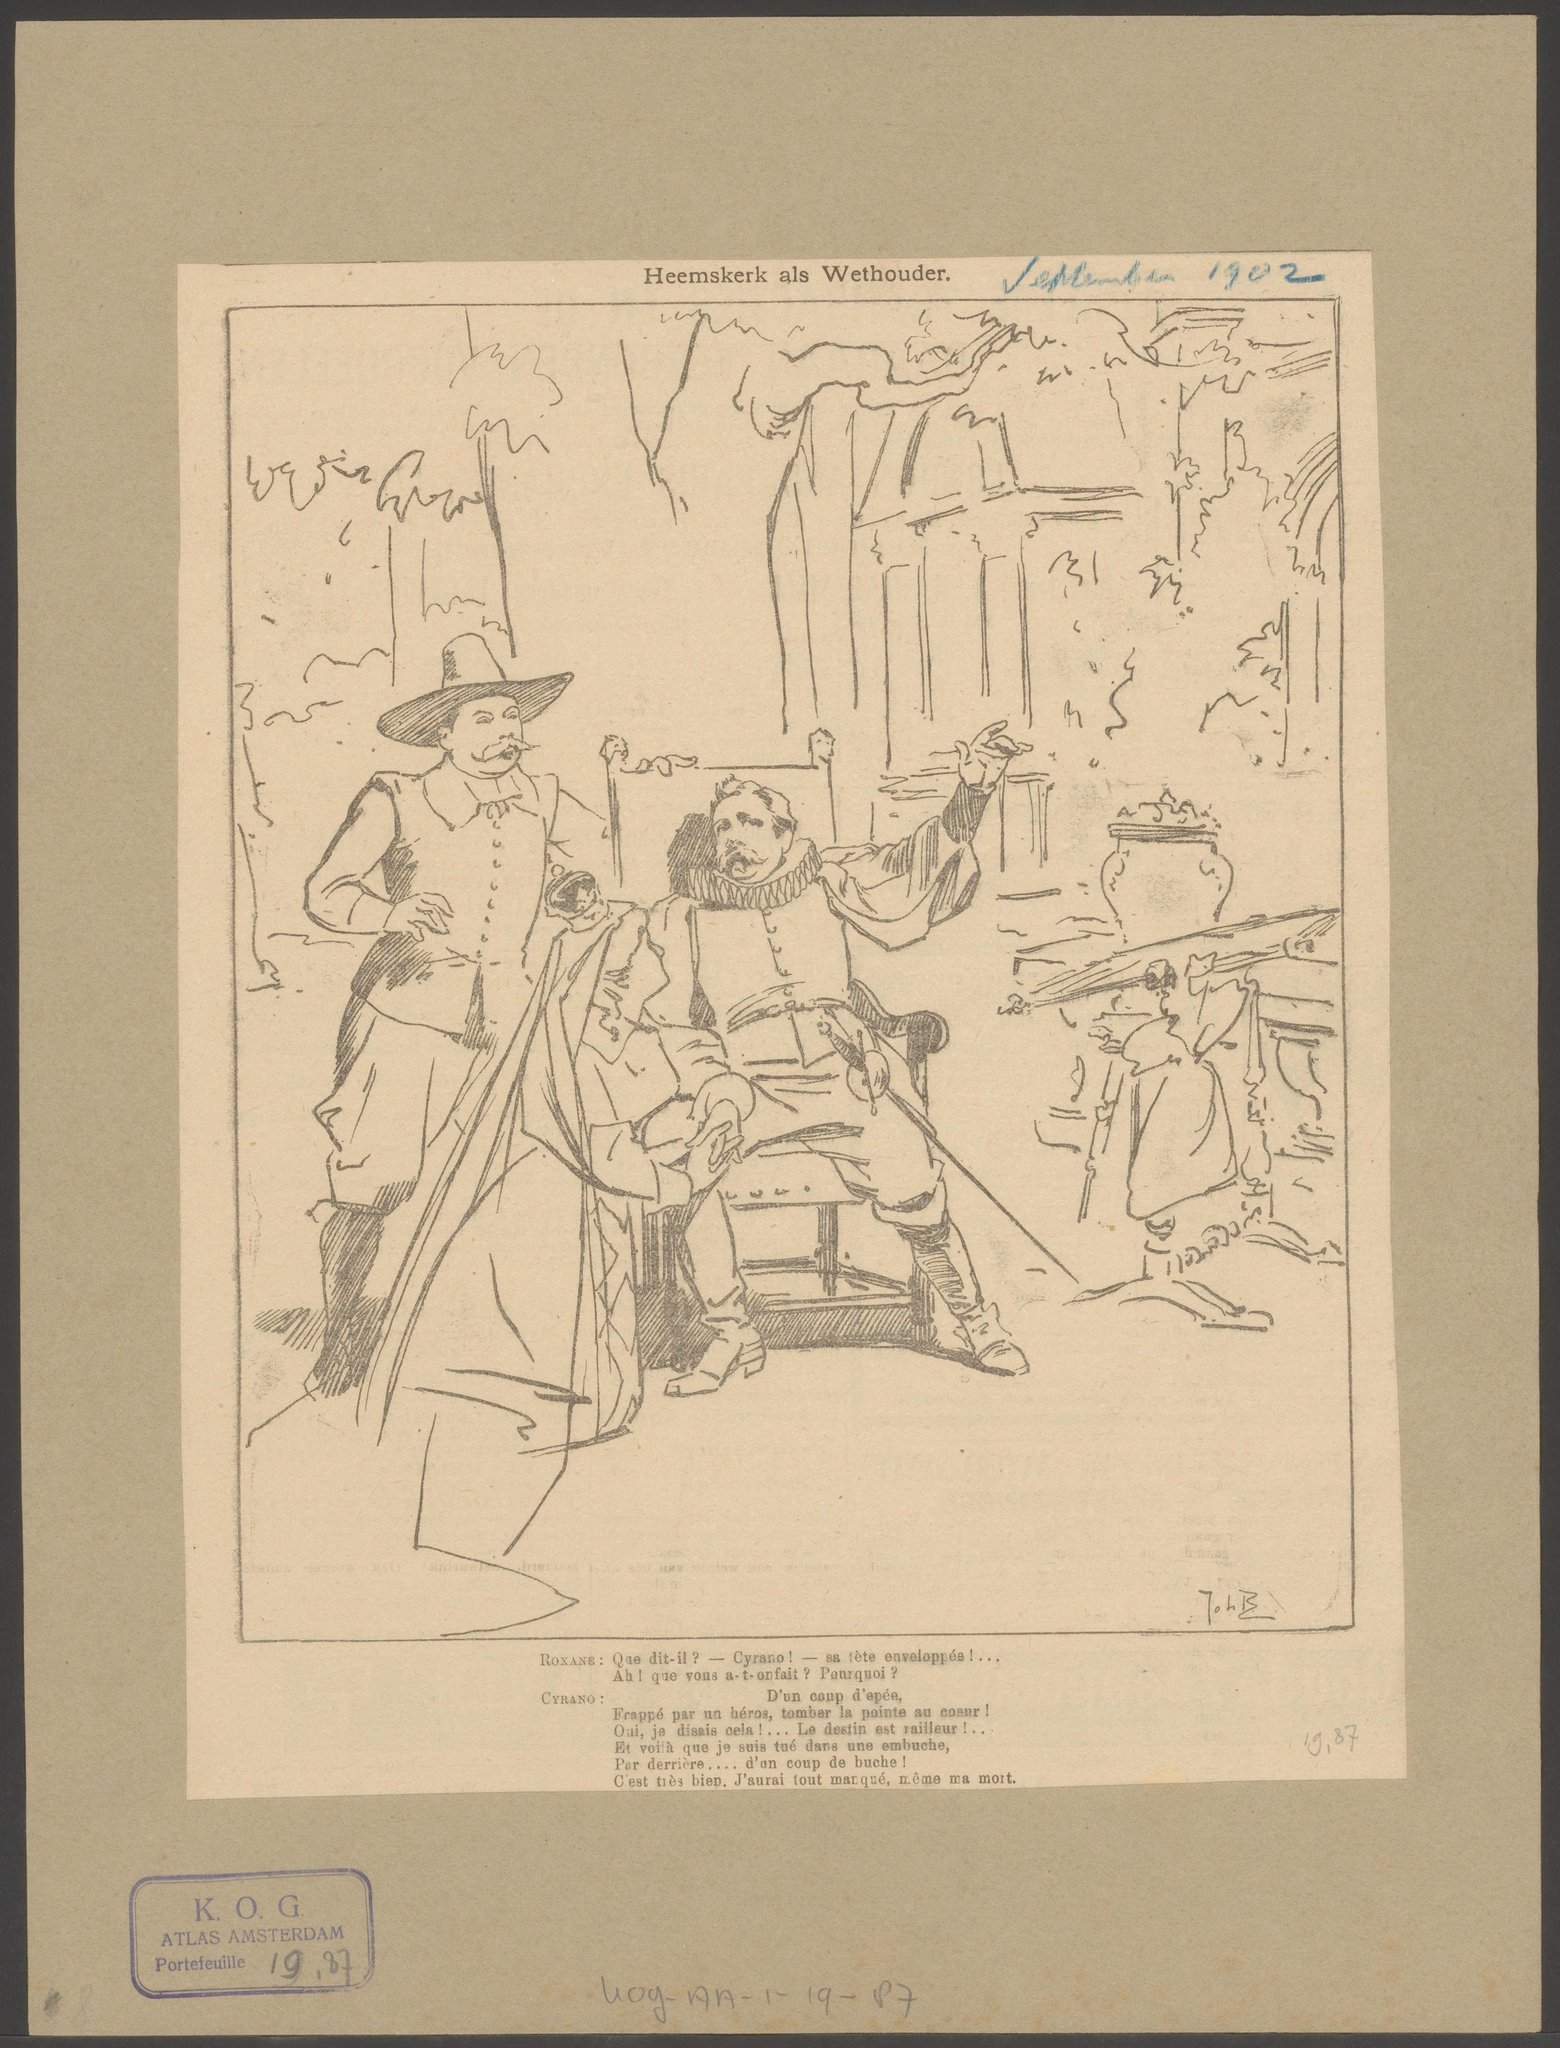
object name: cartoon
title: Heemskerk als Wethouder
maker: johan braakensiek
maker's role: draughtsman, print maker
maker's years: 1858-1940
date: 1901-1909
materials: paper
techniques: letterpress printing, line block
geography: amsterdam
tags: political caricatures and satires, amsterdam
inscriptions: collector's mark: ‘19,87’ Lugt 1641b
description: Onderwerpsrubriek binnen de Atlas Amsterdam: Herinneringen aan regeringsleden en hunne huisgezinnen [na 1800].